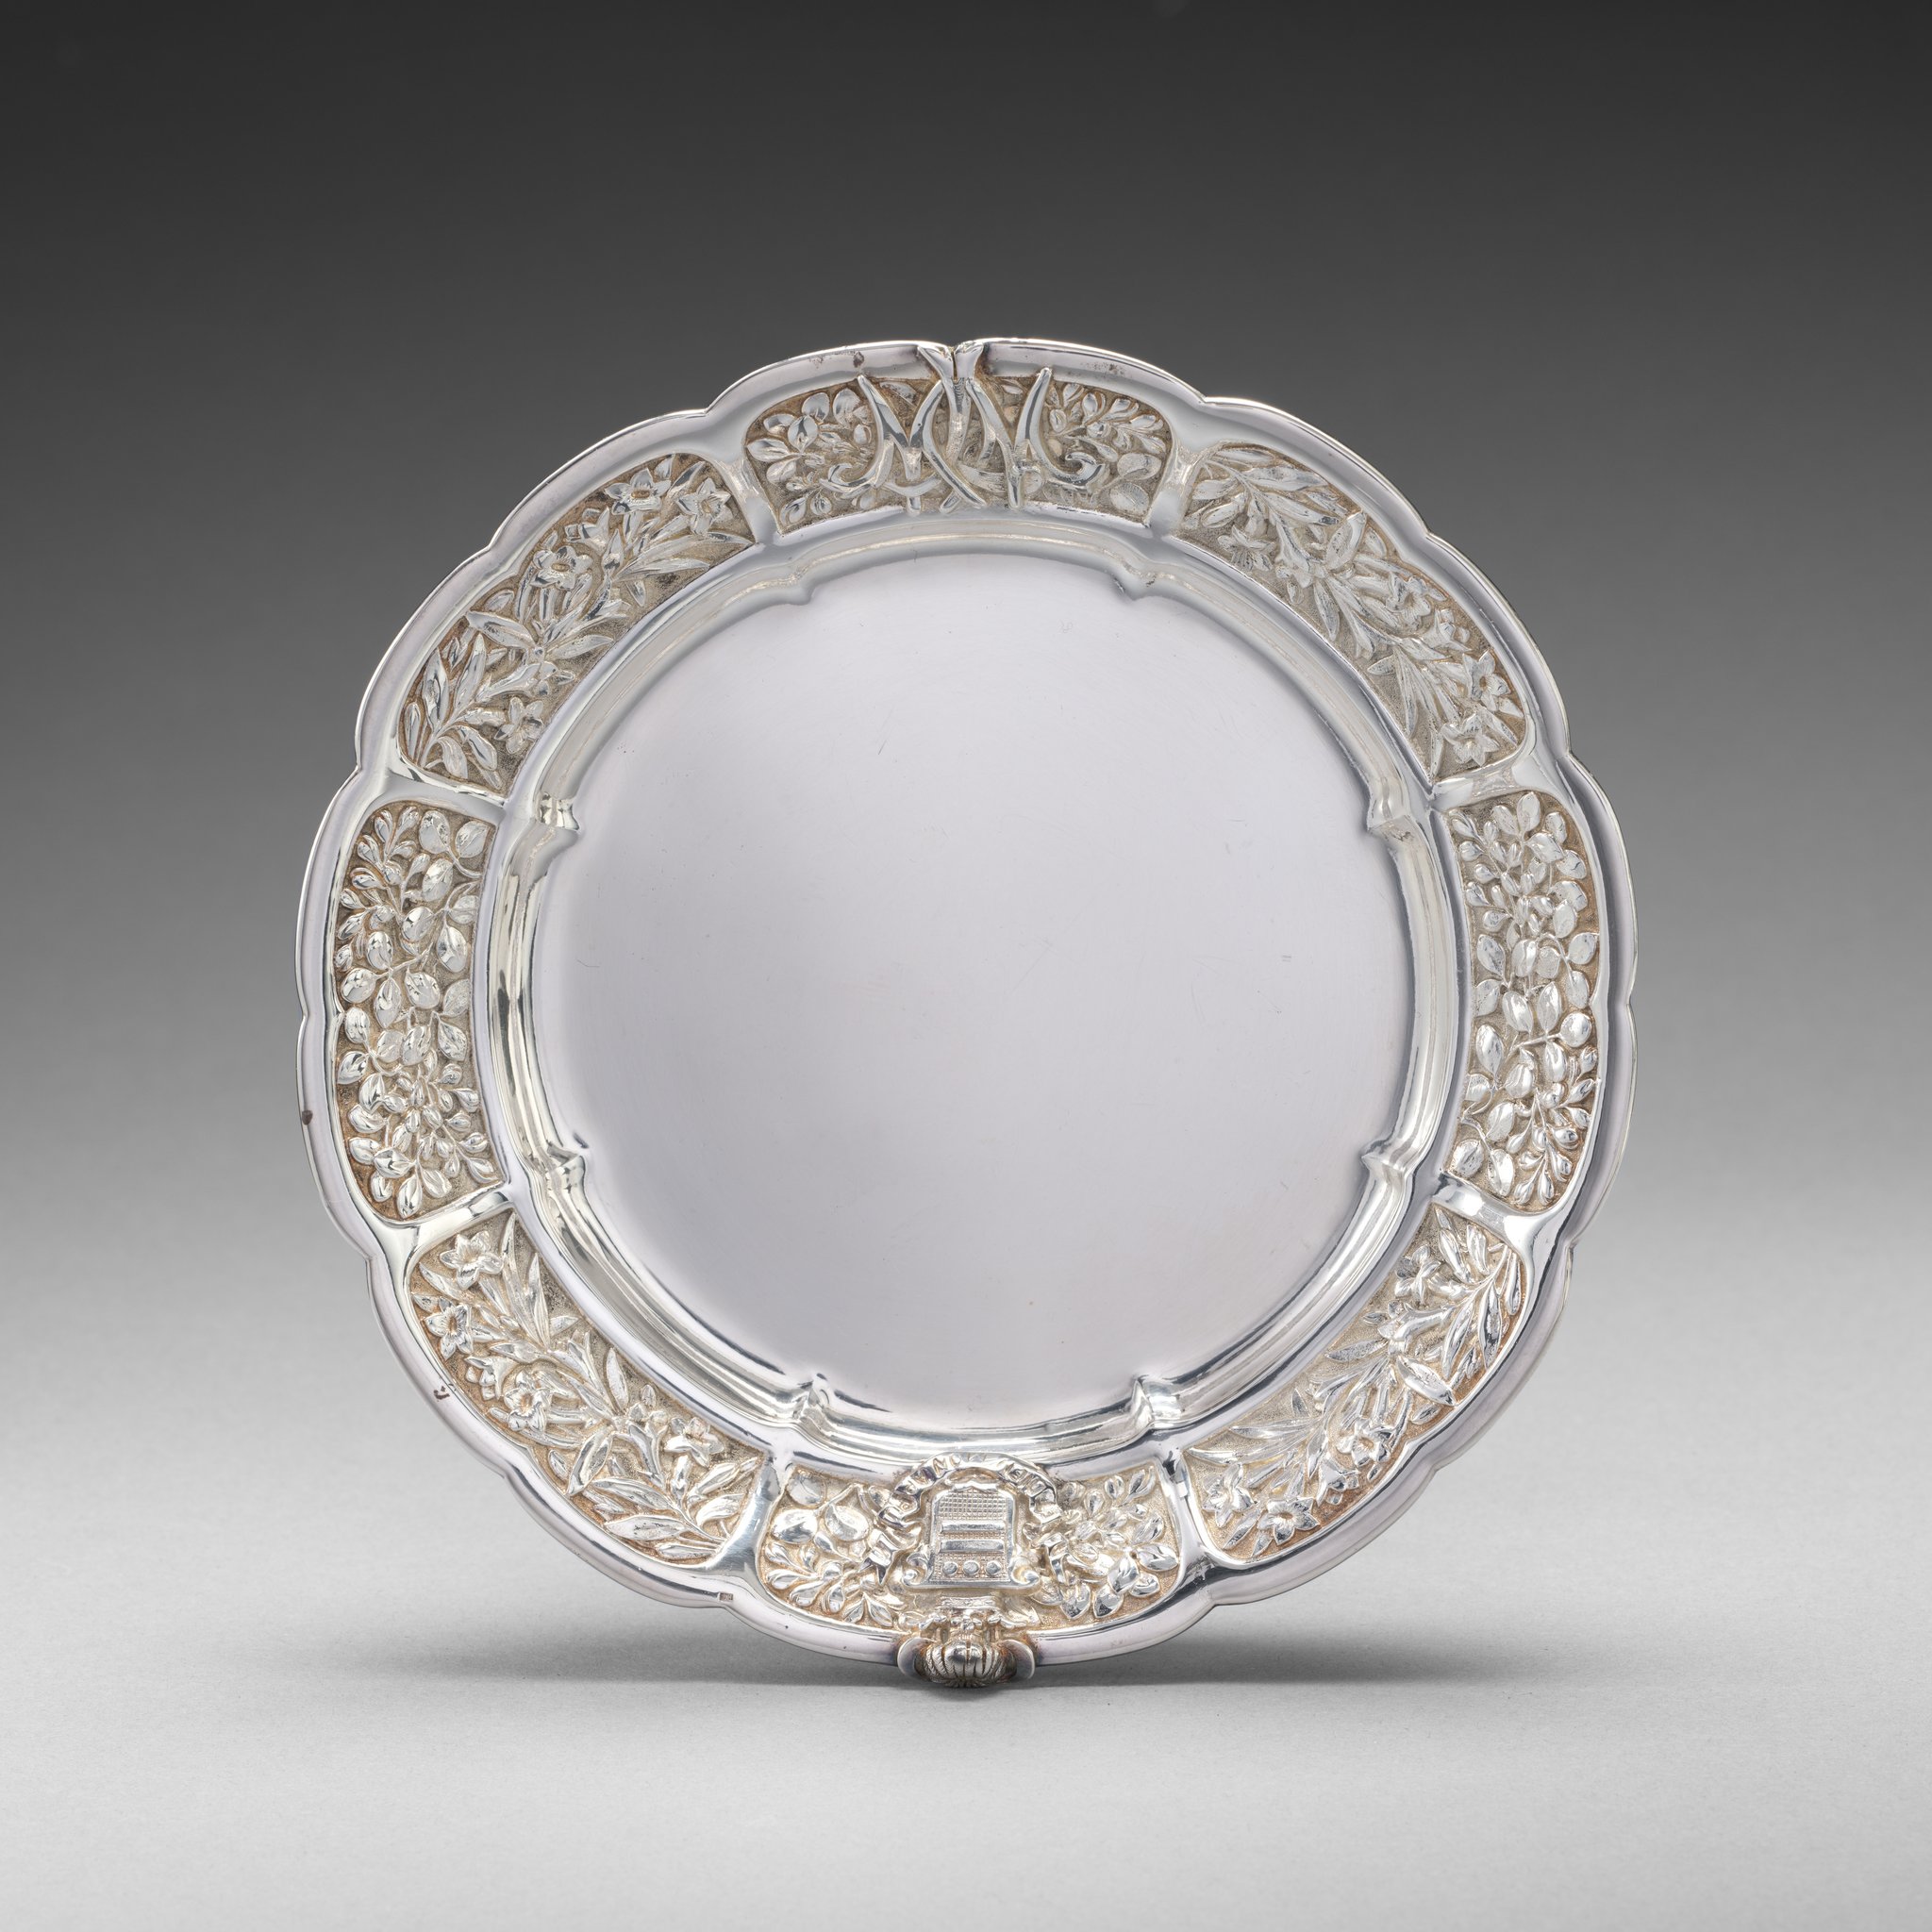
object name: ice cream plate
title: Ice Cream Plate from Mackay Service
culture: american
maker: tiffany & co.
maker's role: maker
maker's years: 1837-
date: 1878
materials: silver